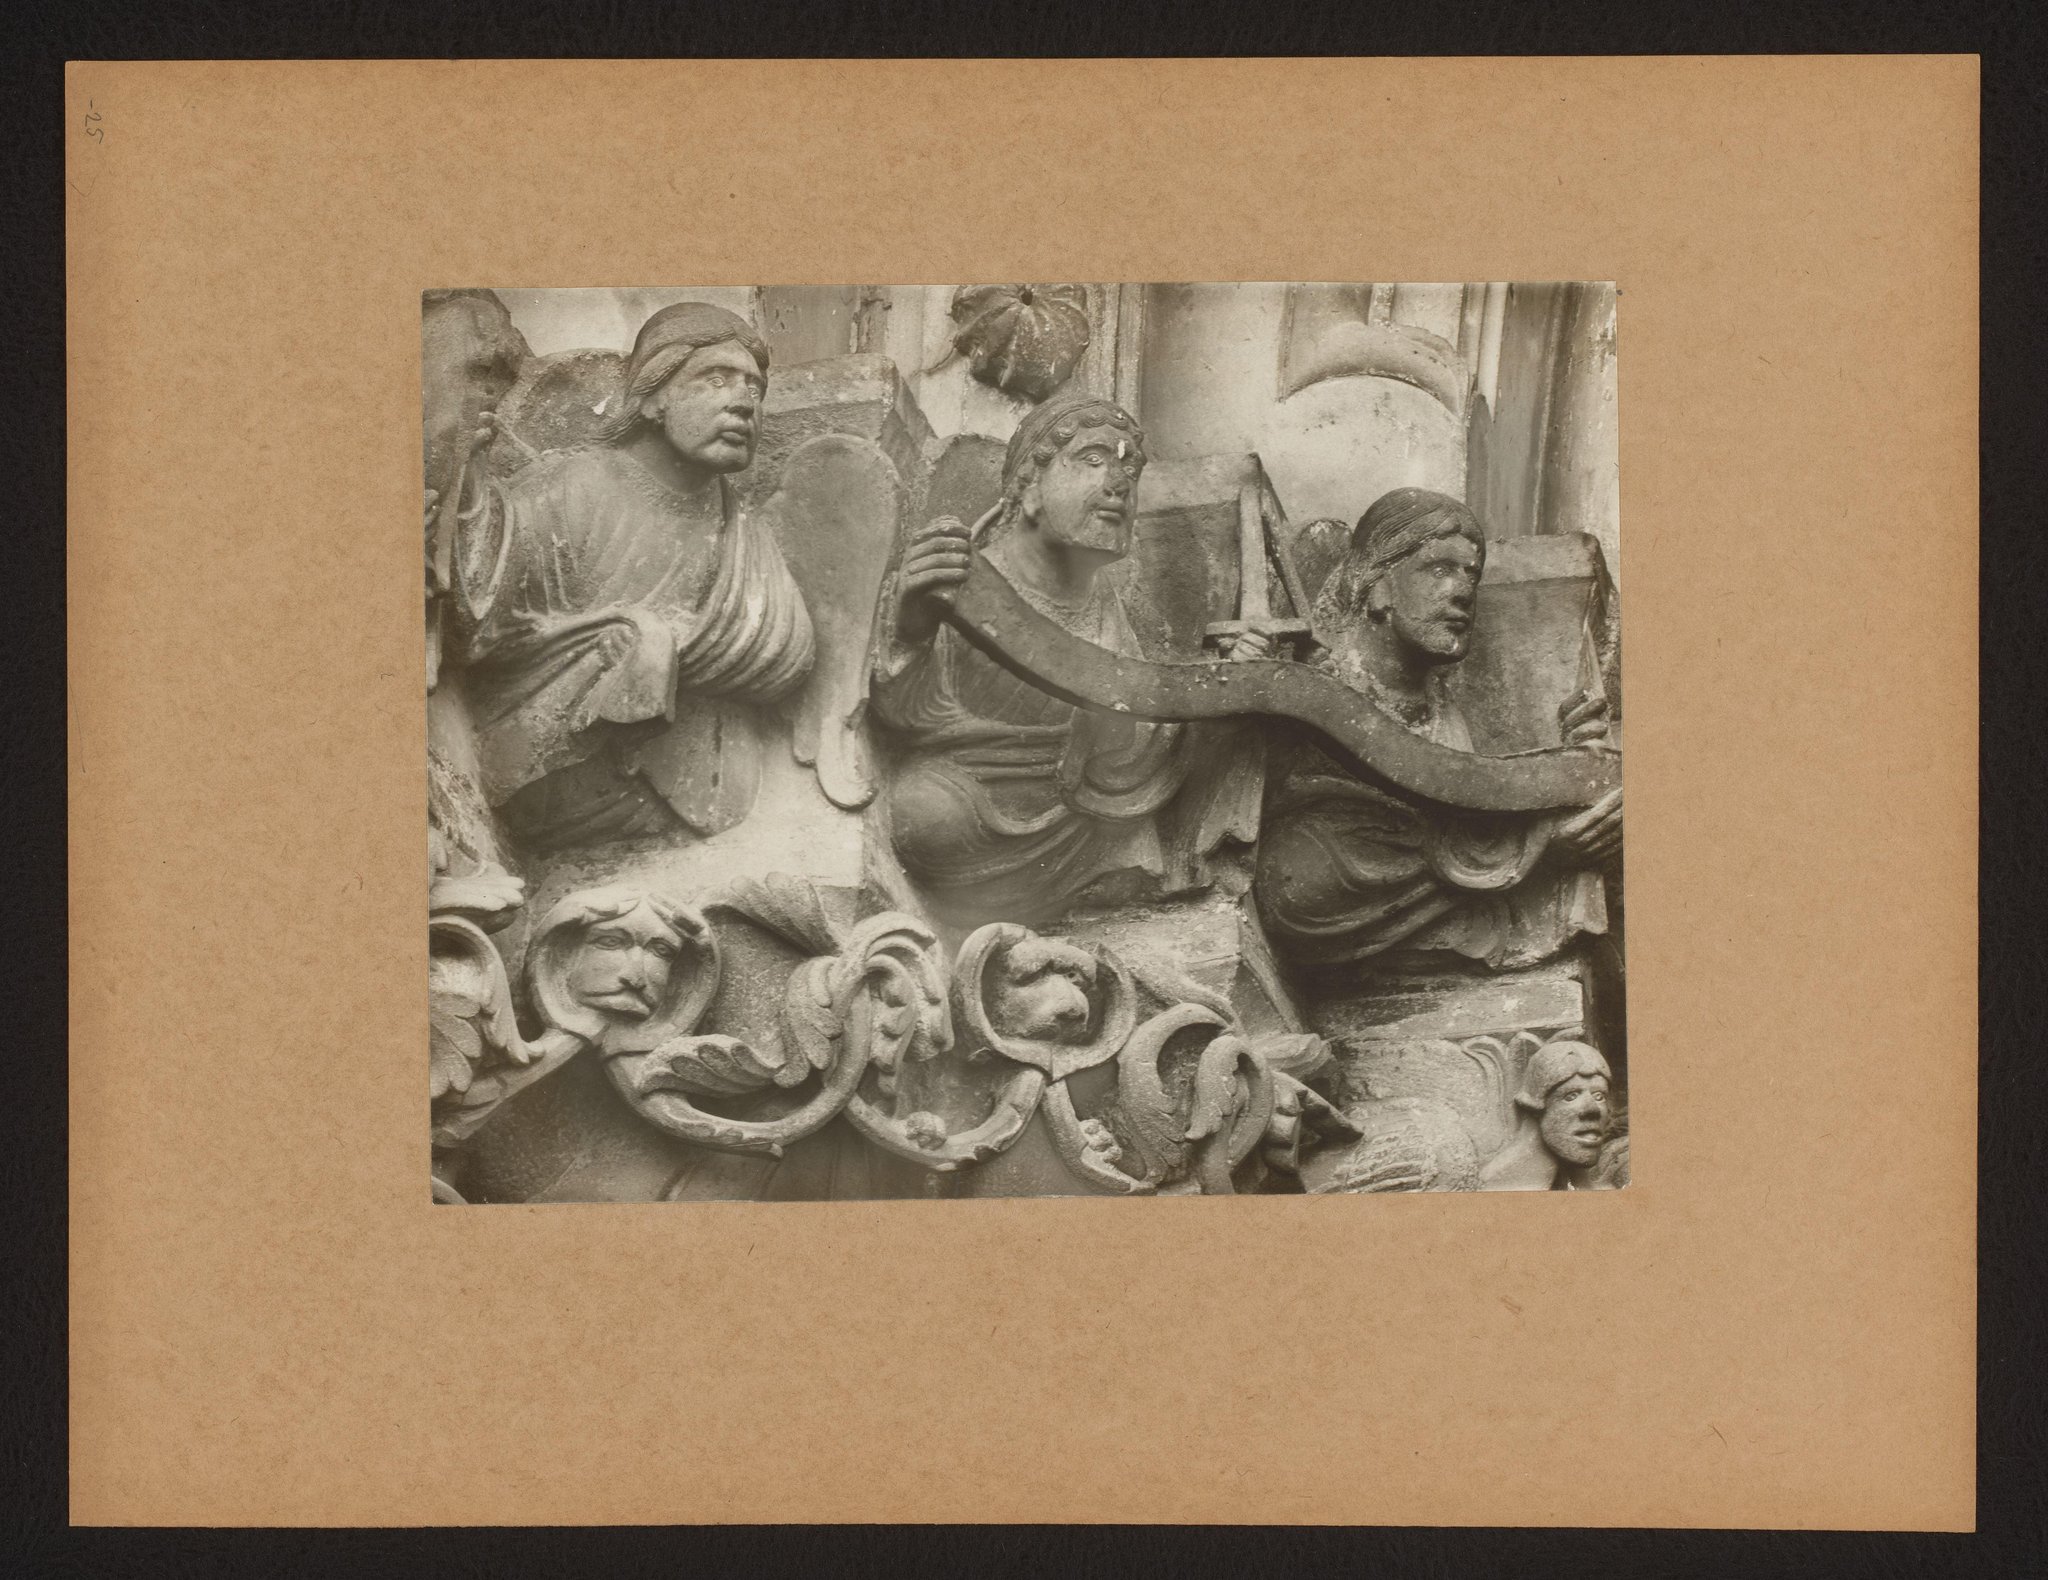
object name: photograph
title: Detail van een kapiteel van de Gnadenpforte in de dom van Bamberg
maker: Anonymous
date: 1900-1920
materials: paper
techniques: gelatin silver print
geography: bamberg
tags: church (exterior)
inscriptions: number: ‘25.’